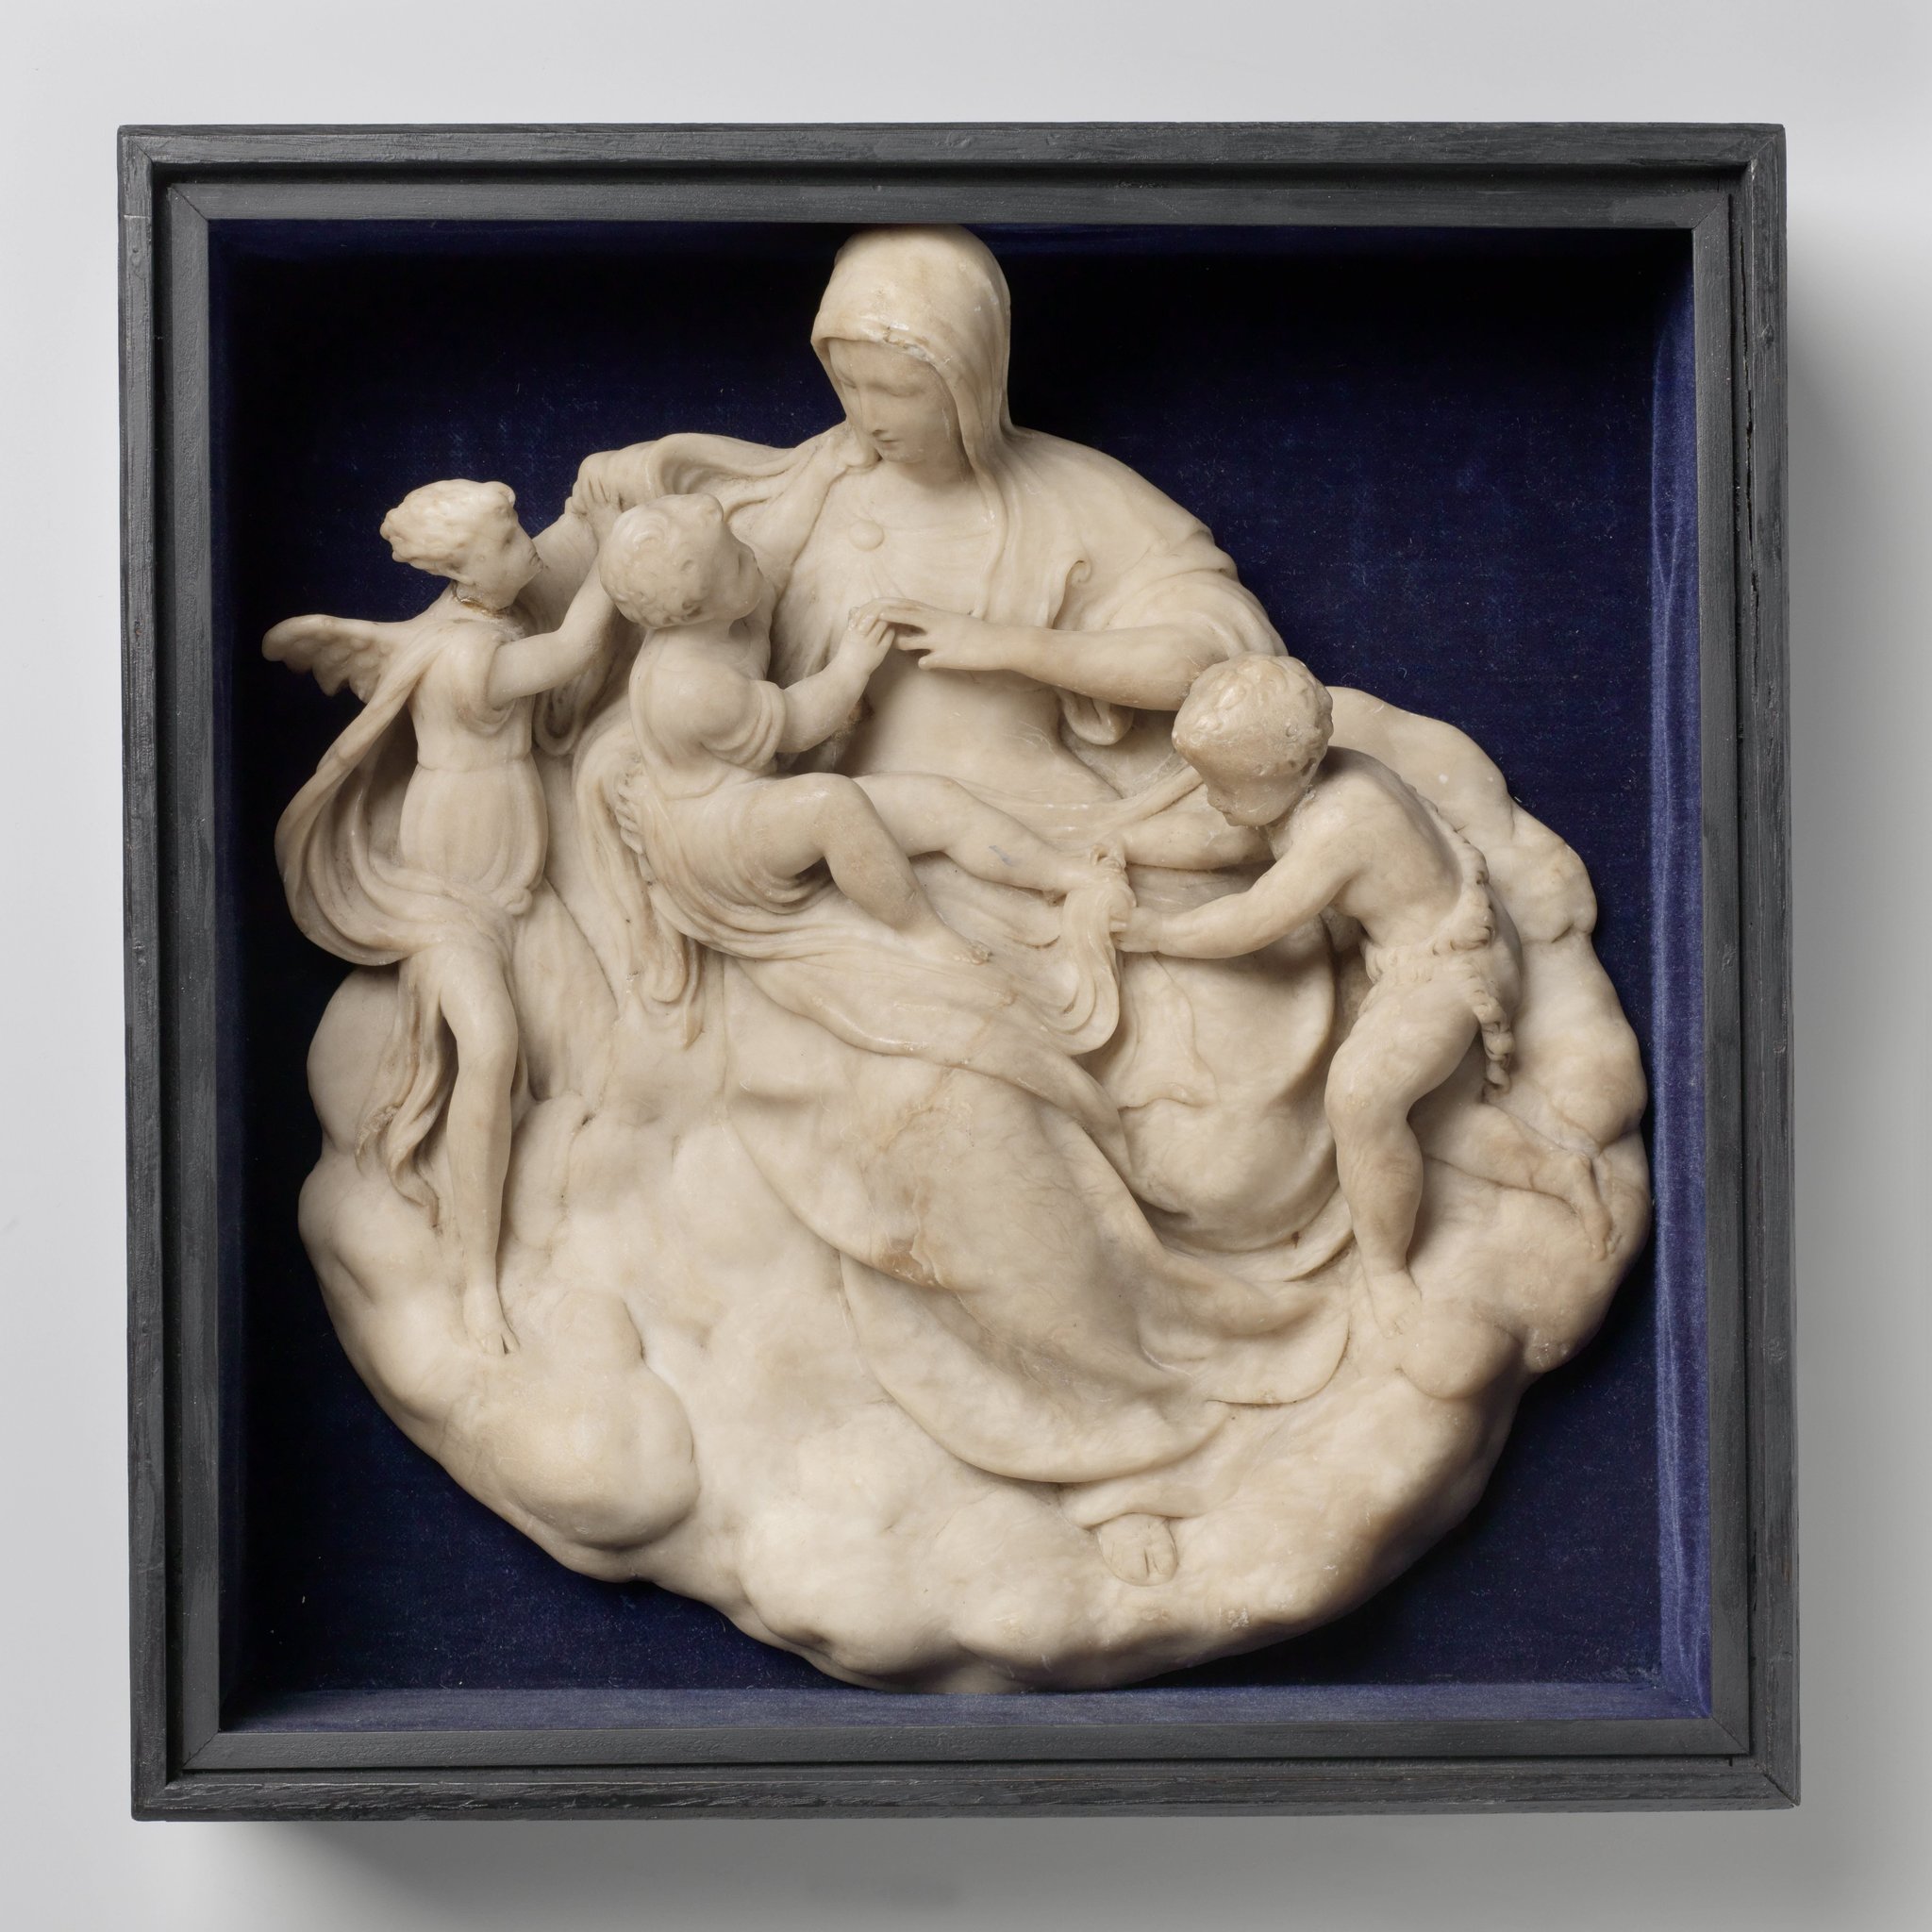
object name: sculpture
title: Virgin and Child Seated on Clouds with St John the Baptist and an Angel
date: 1540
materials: alabaster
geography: mechelen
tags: mary and the christ-child with john the baptist (as child) (+ angel(s))